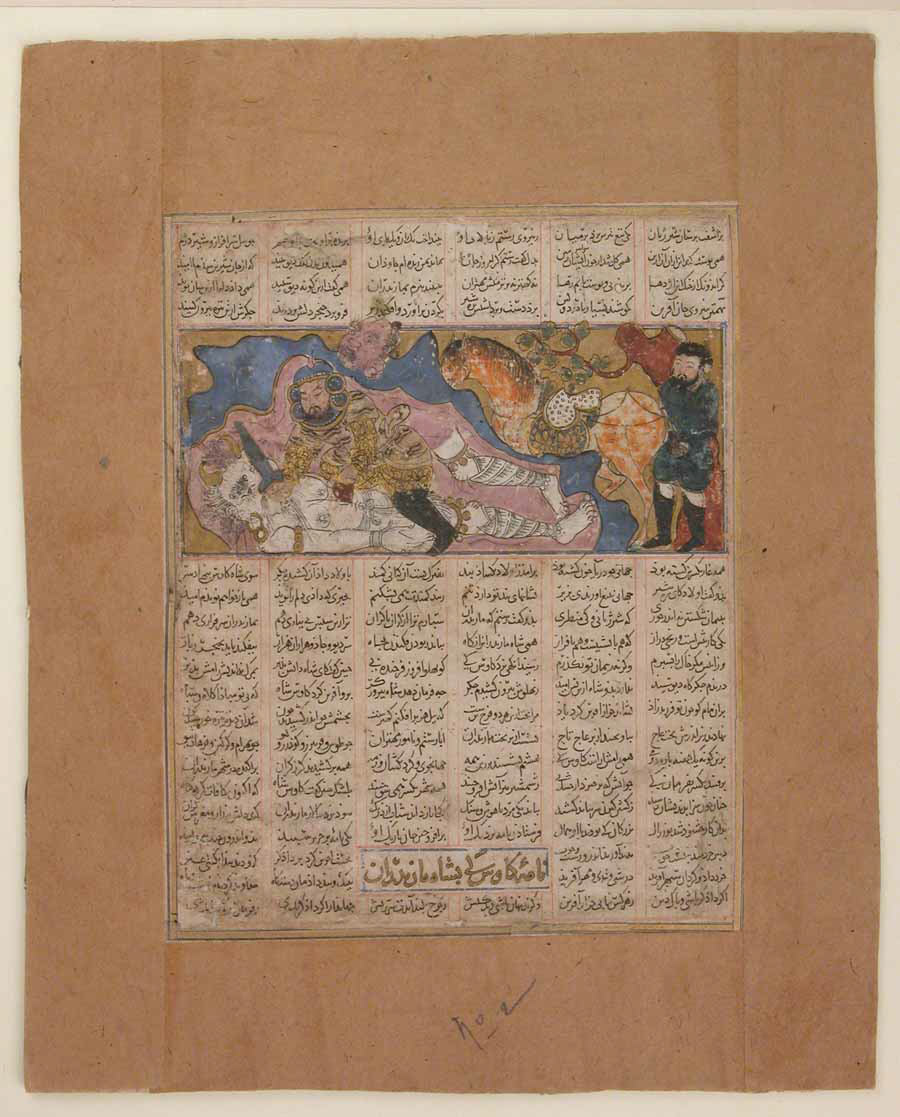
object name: folio from an illustrated manuscript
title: "Rustam Kills the White Div", Folio from a Shahnama (Book of Kings)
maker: abu'l qasim firdausi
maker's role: author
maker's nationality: iranian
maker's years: 935-1020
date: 1300-1330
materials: gold, ink, paper, silver, watercolor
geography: iran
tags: men,horses,calligraphy